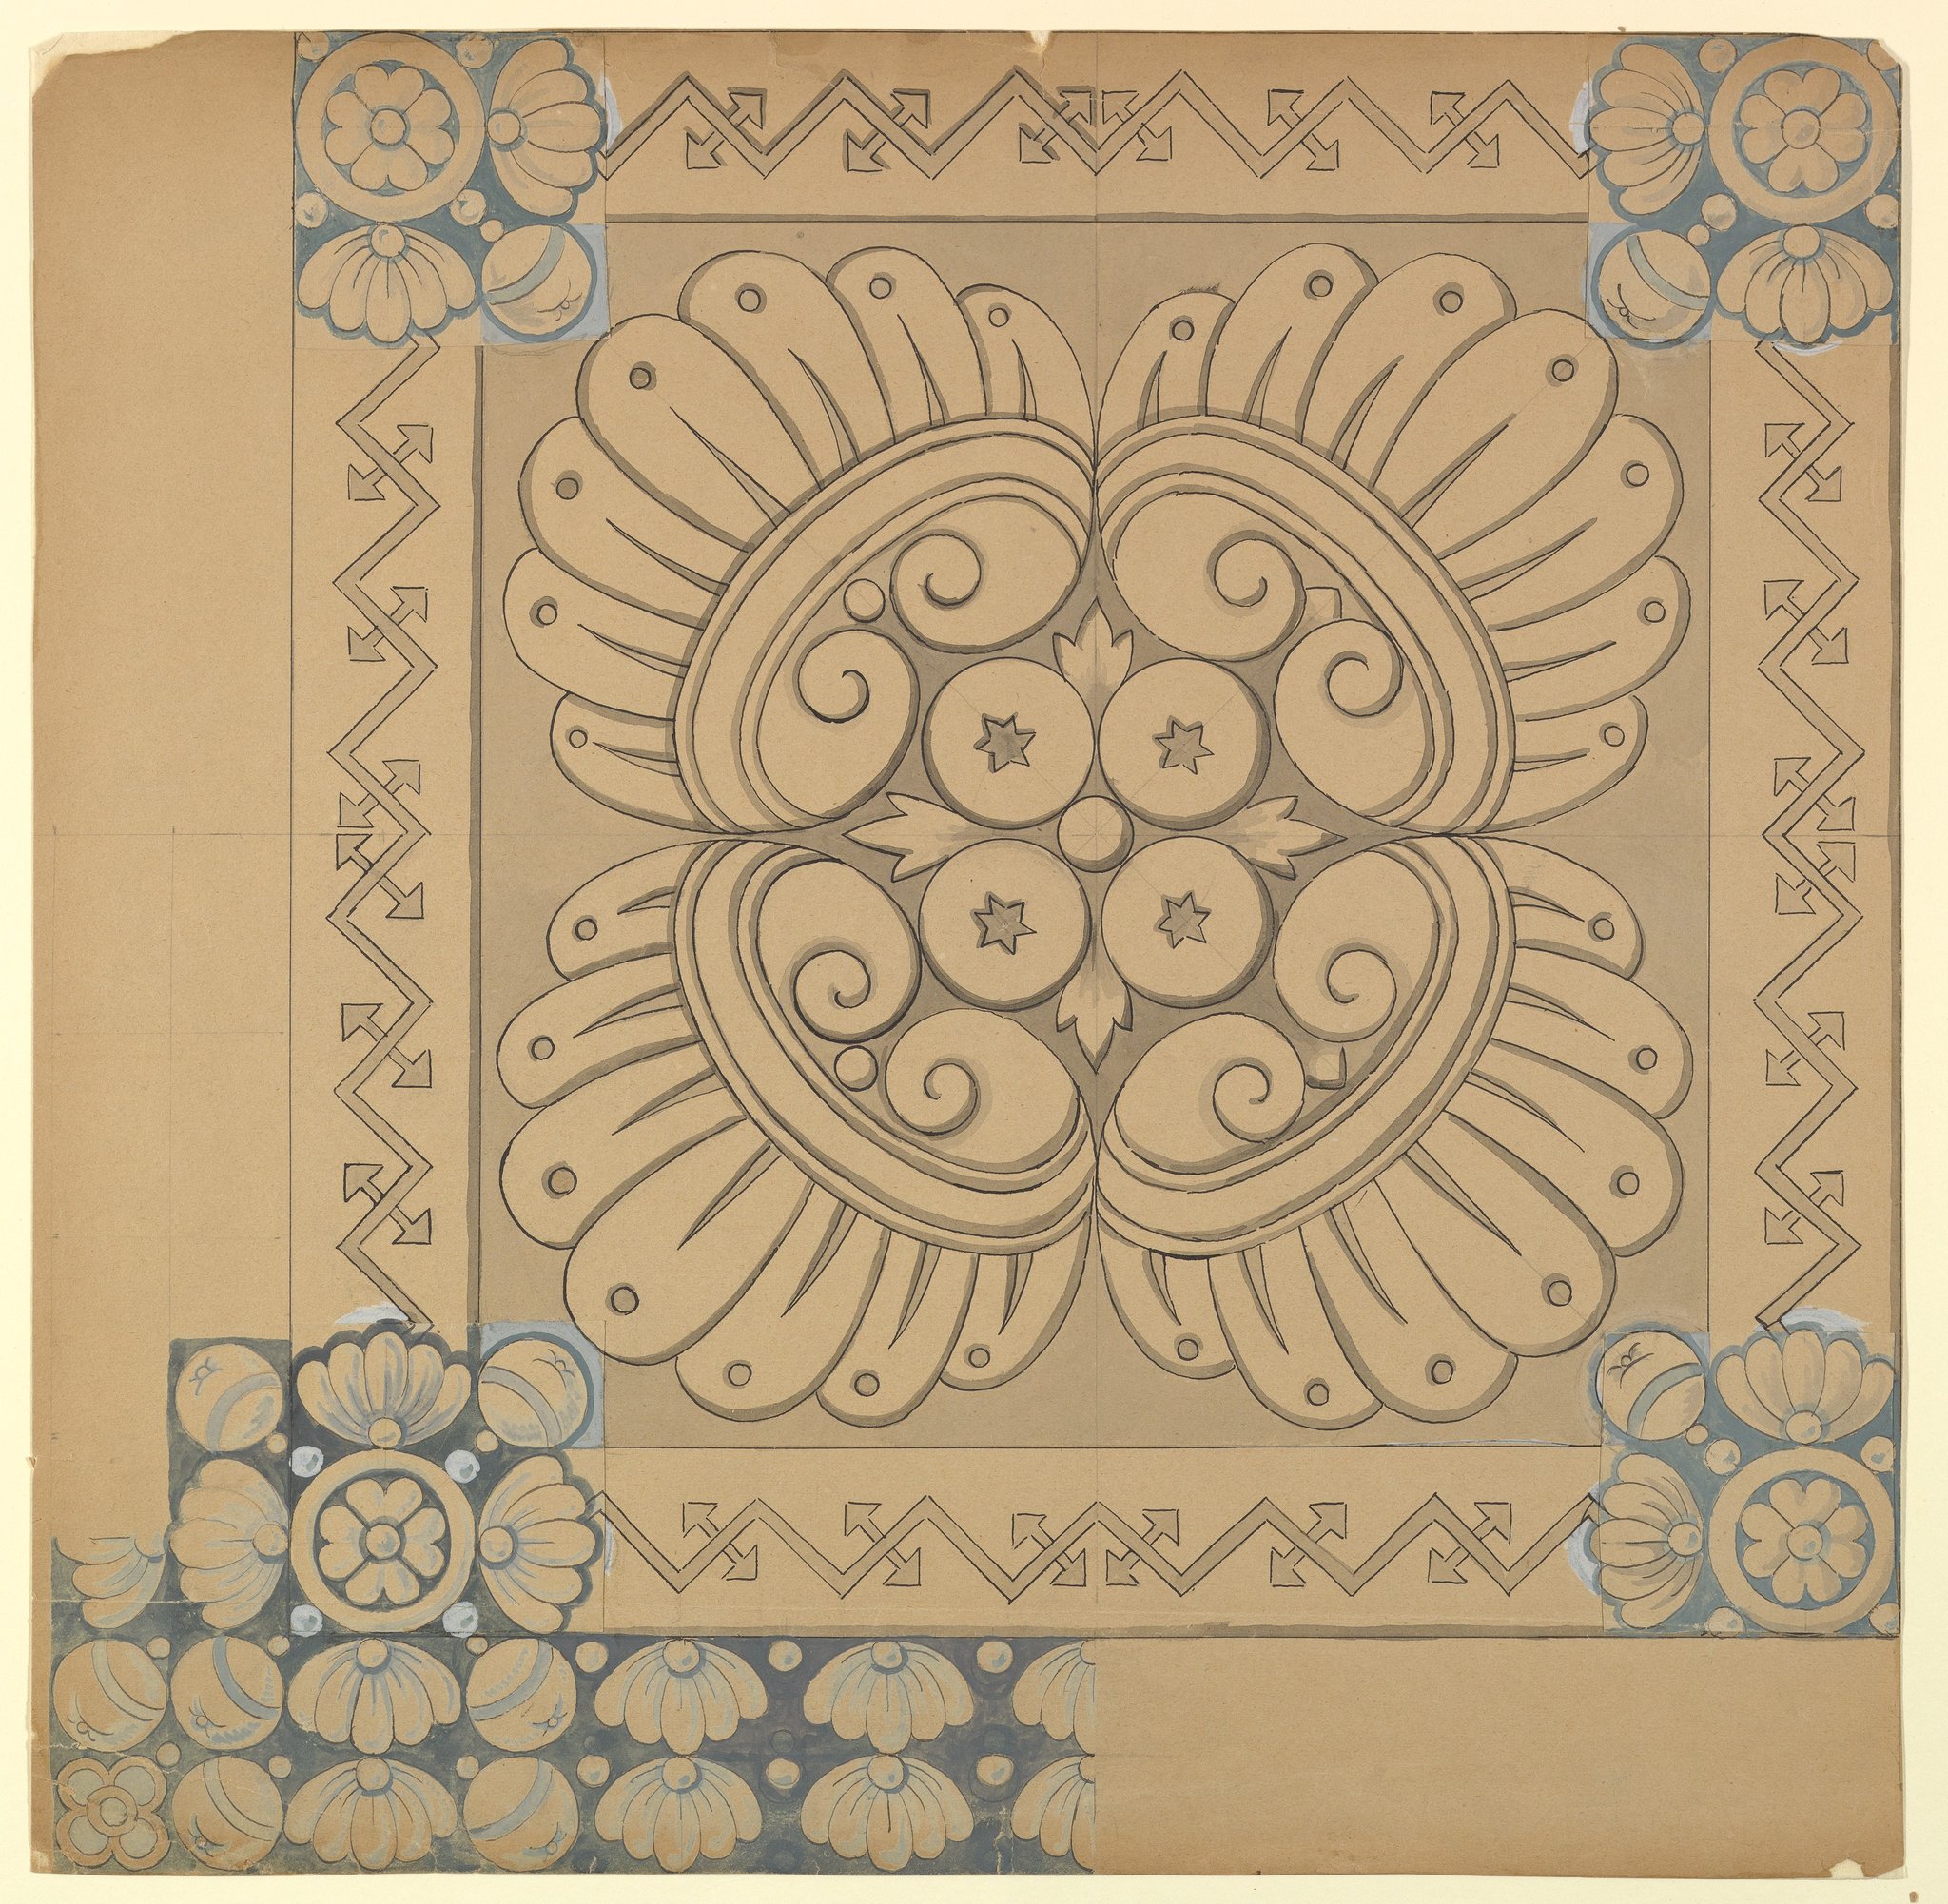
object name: drawing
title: Design for Ornamented Tile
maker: carl faber, stuttgart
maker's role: designer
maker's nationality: german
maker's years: 1837-1900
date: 1801-1900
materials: gouache, graphite, ink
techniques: pen, drawing, wash